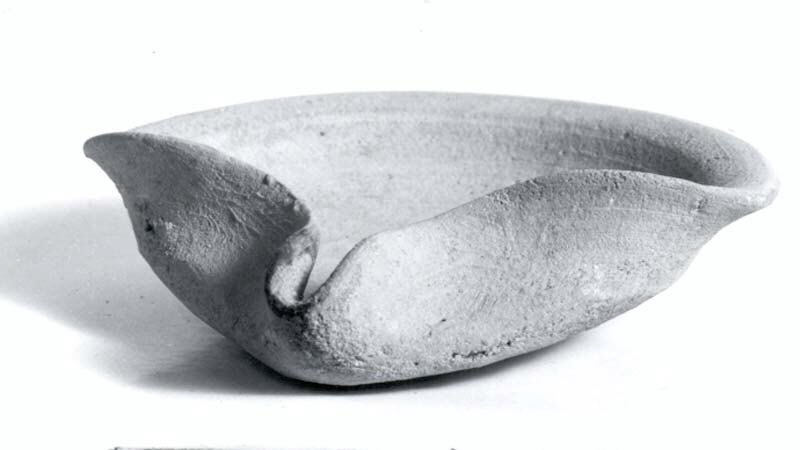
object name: lamp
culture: israelite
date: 734-601 BCE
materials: ceramic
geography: levant